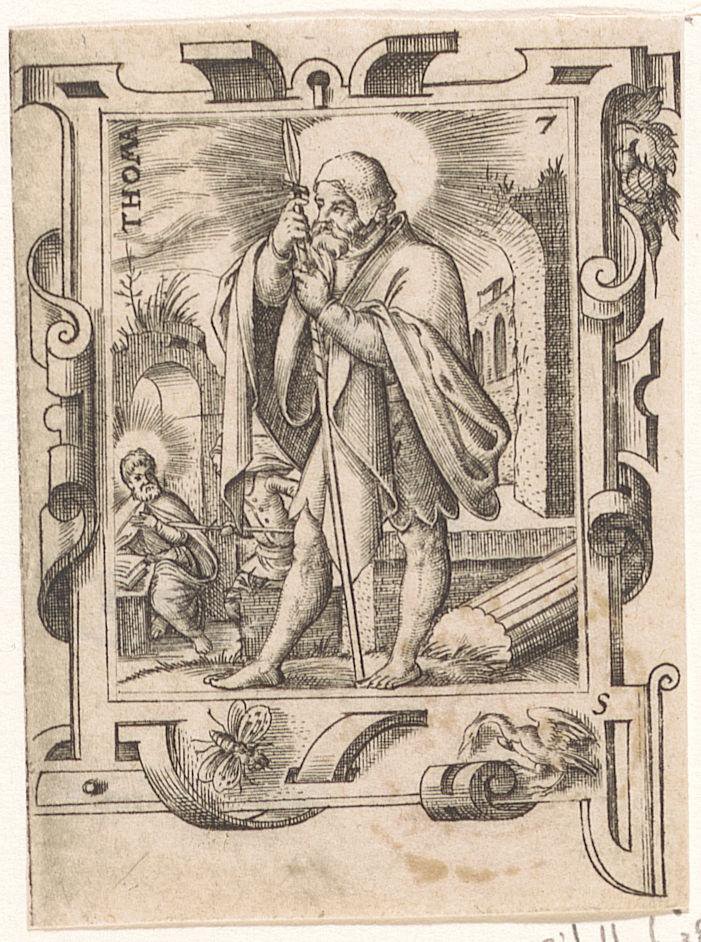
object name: print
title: Heilige Tomas in een rolwerk omlijsting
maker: virgilius solis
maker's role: draughtsman, print maker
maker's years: 1514-1562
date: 1568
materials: paper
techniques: engraving, etching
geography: nuremberg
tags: the apostle thomas; possible attributes: book, chalice, girdle, heart, lance or spear, scroll, square, stones, scrollwork, strapwork ~ ornament, death of thomas: he is brought out of the city by four soldiers, who kill him with their lances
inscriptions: collector's mark: Lugt 240, number: ‘87’, collector's mark: Lugt 2228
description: Prent gebruikt voor het gebedenboek: Solis, Virgil. Ein New Künstlich Betbüchlein. Neurenberg: Hieronymus Petri, 1568. Bij elke prent met afbeelding van een apostel behoort een prent met een gebed in het Latijn en in het Duits. Bij elkaar horende prenten hebben dezelfde nummering en het monogram VS is steeds verspreid over twee bladen met dezelfde nummering.